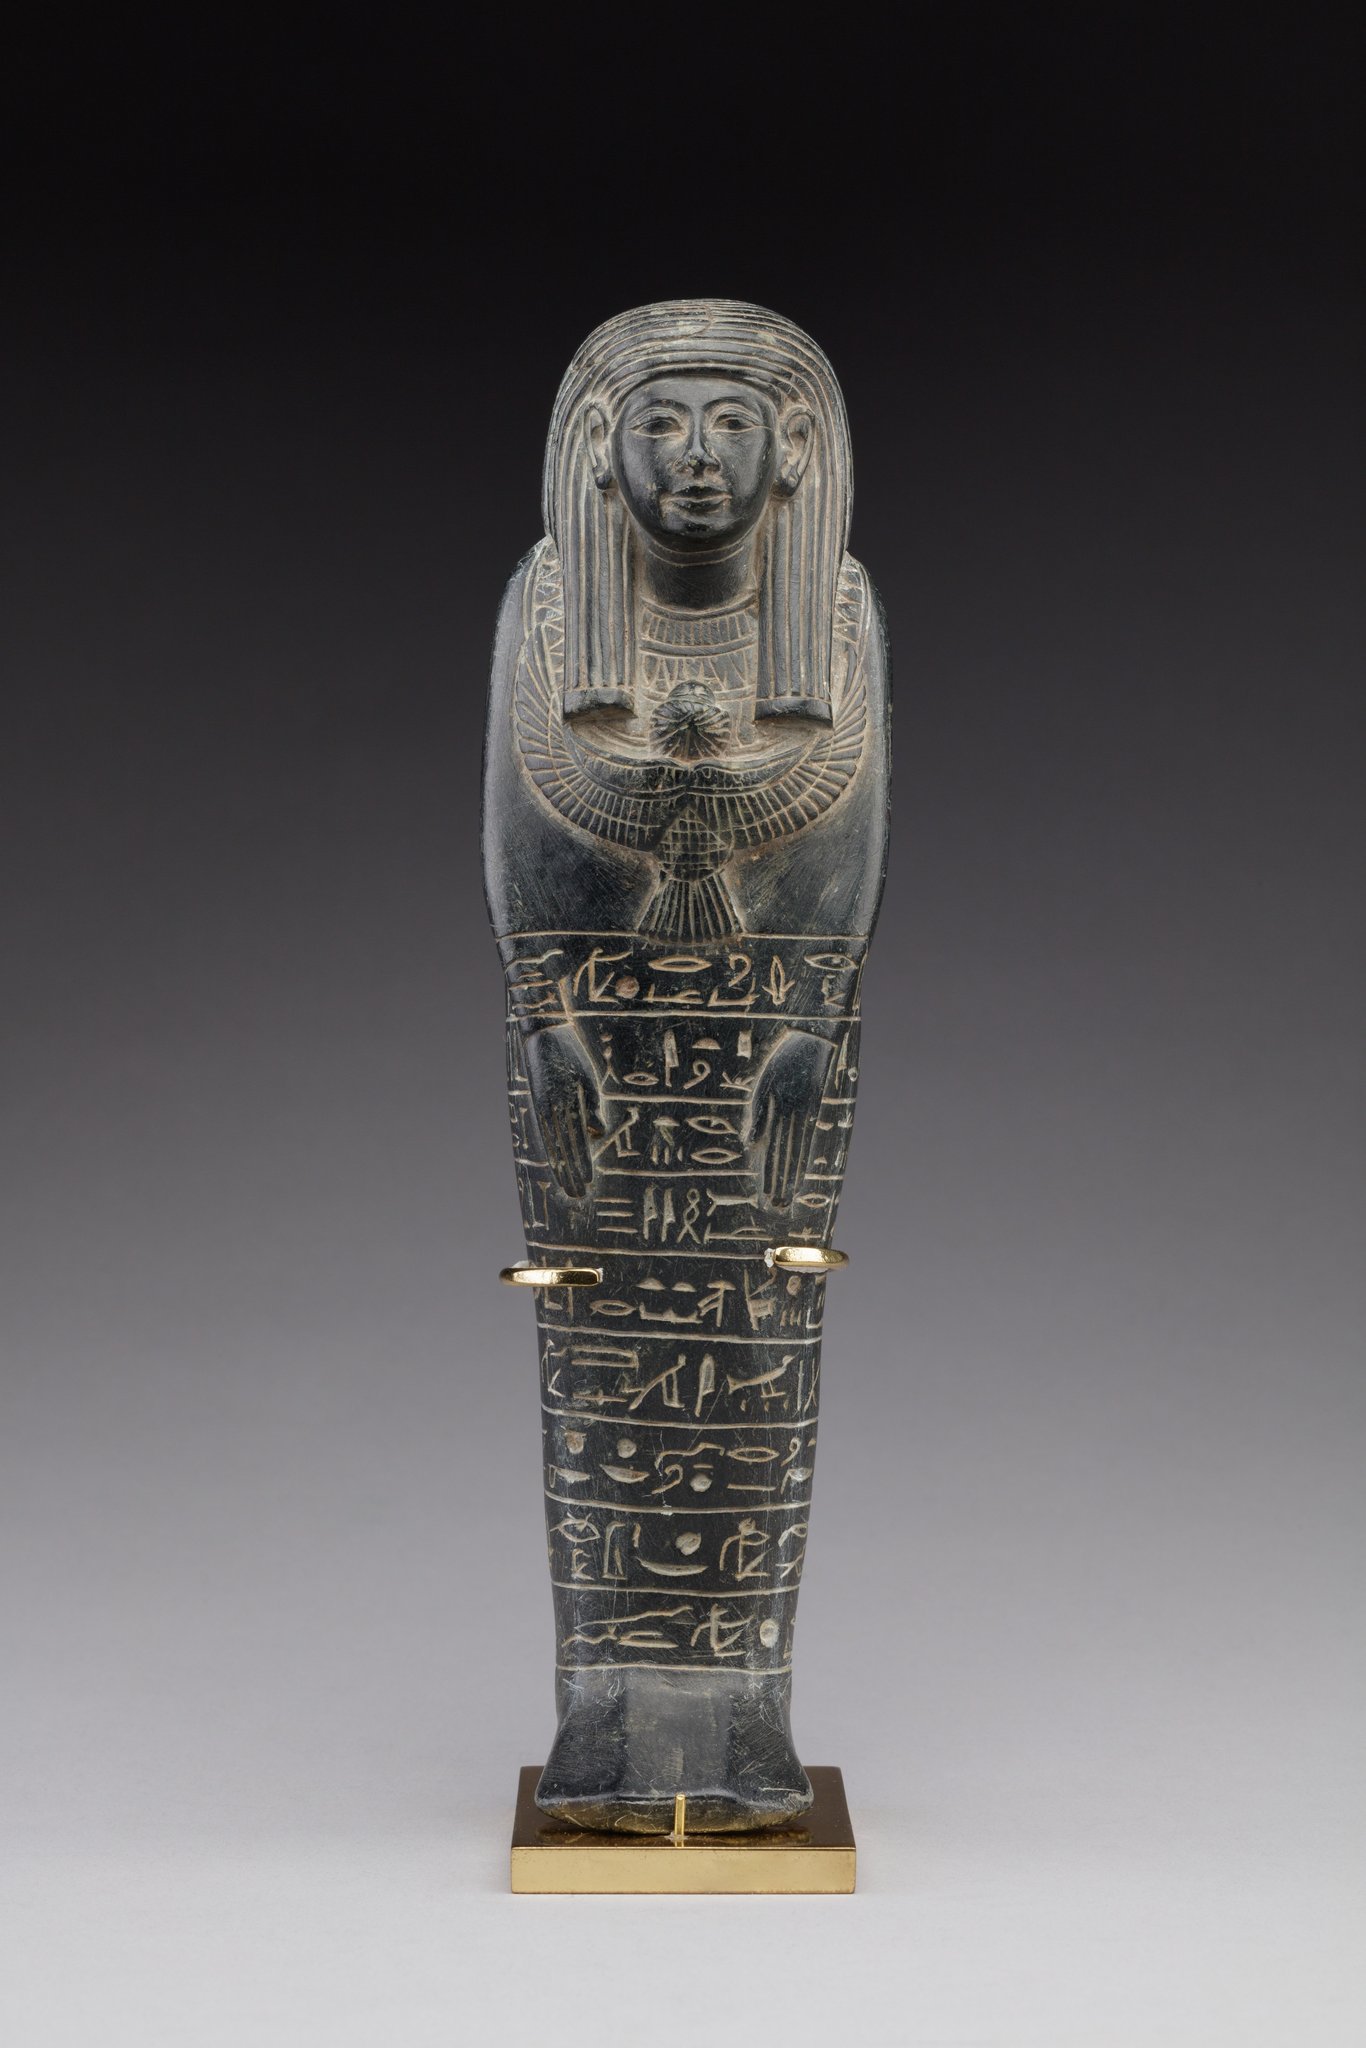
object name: shabti, tjebure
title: Shabti of Tjebure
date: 1295-1186 BCE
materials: stone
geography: egypt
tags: hieroglyphs